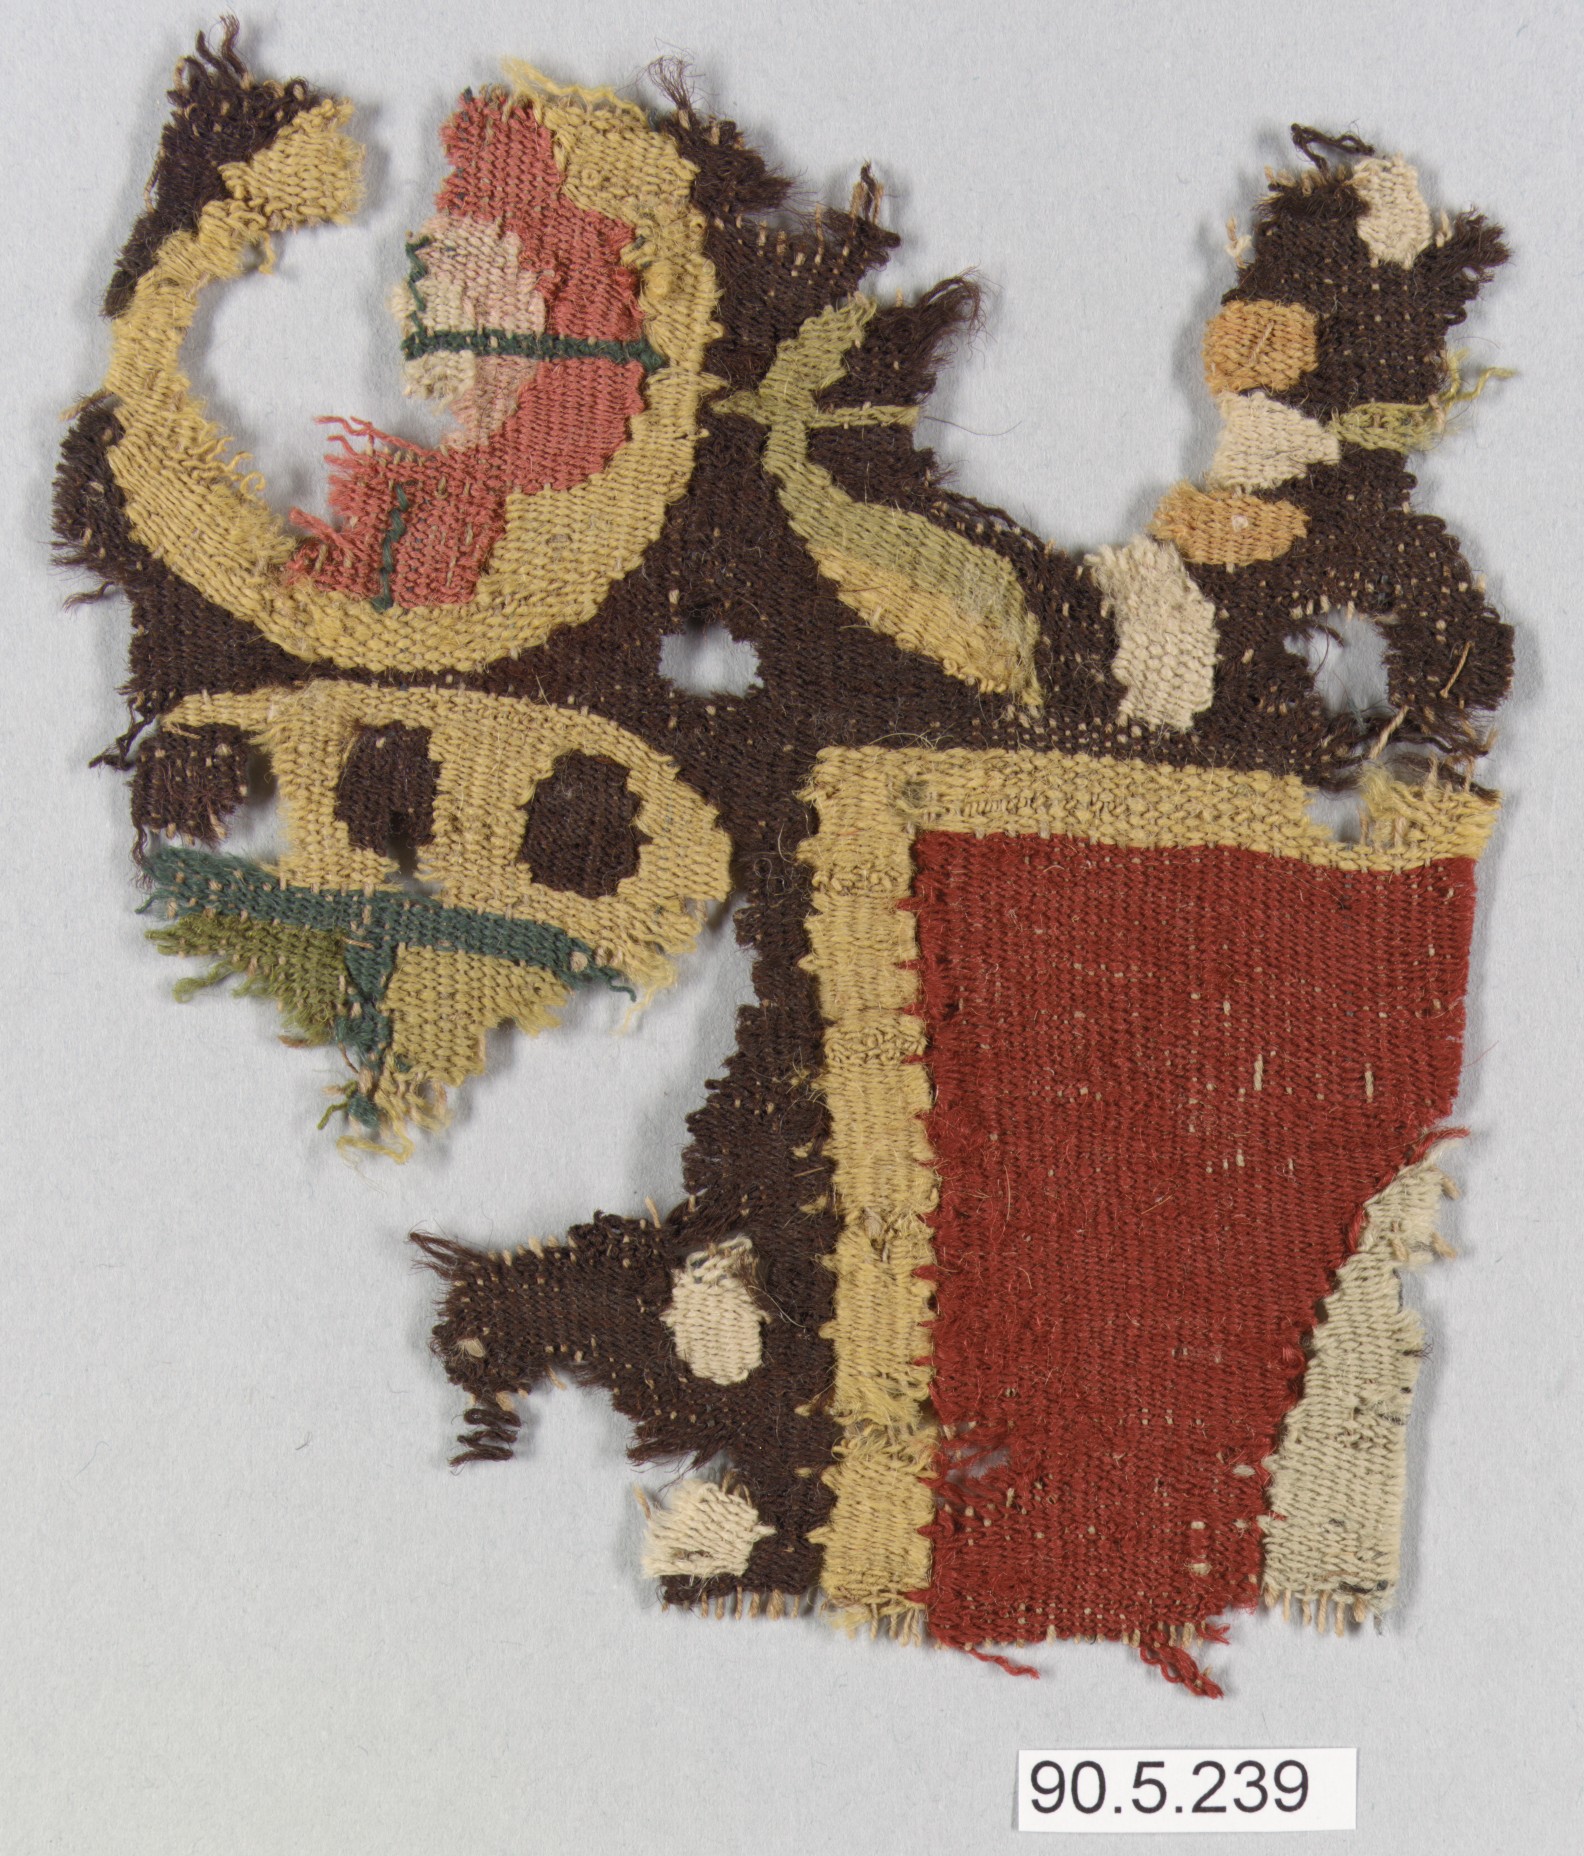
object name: textile fragment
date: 401-600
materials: linen, wool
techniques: weave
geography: egypt